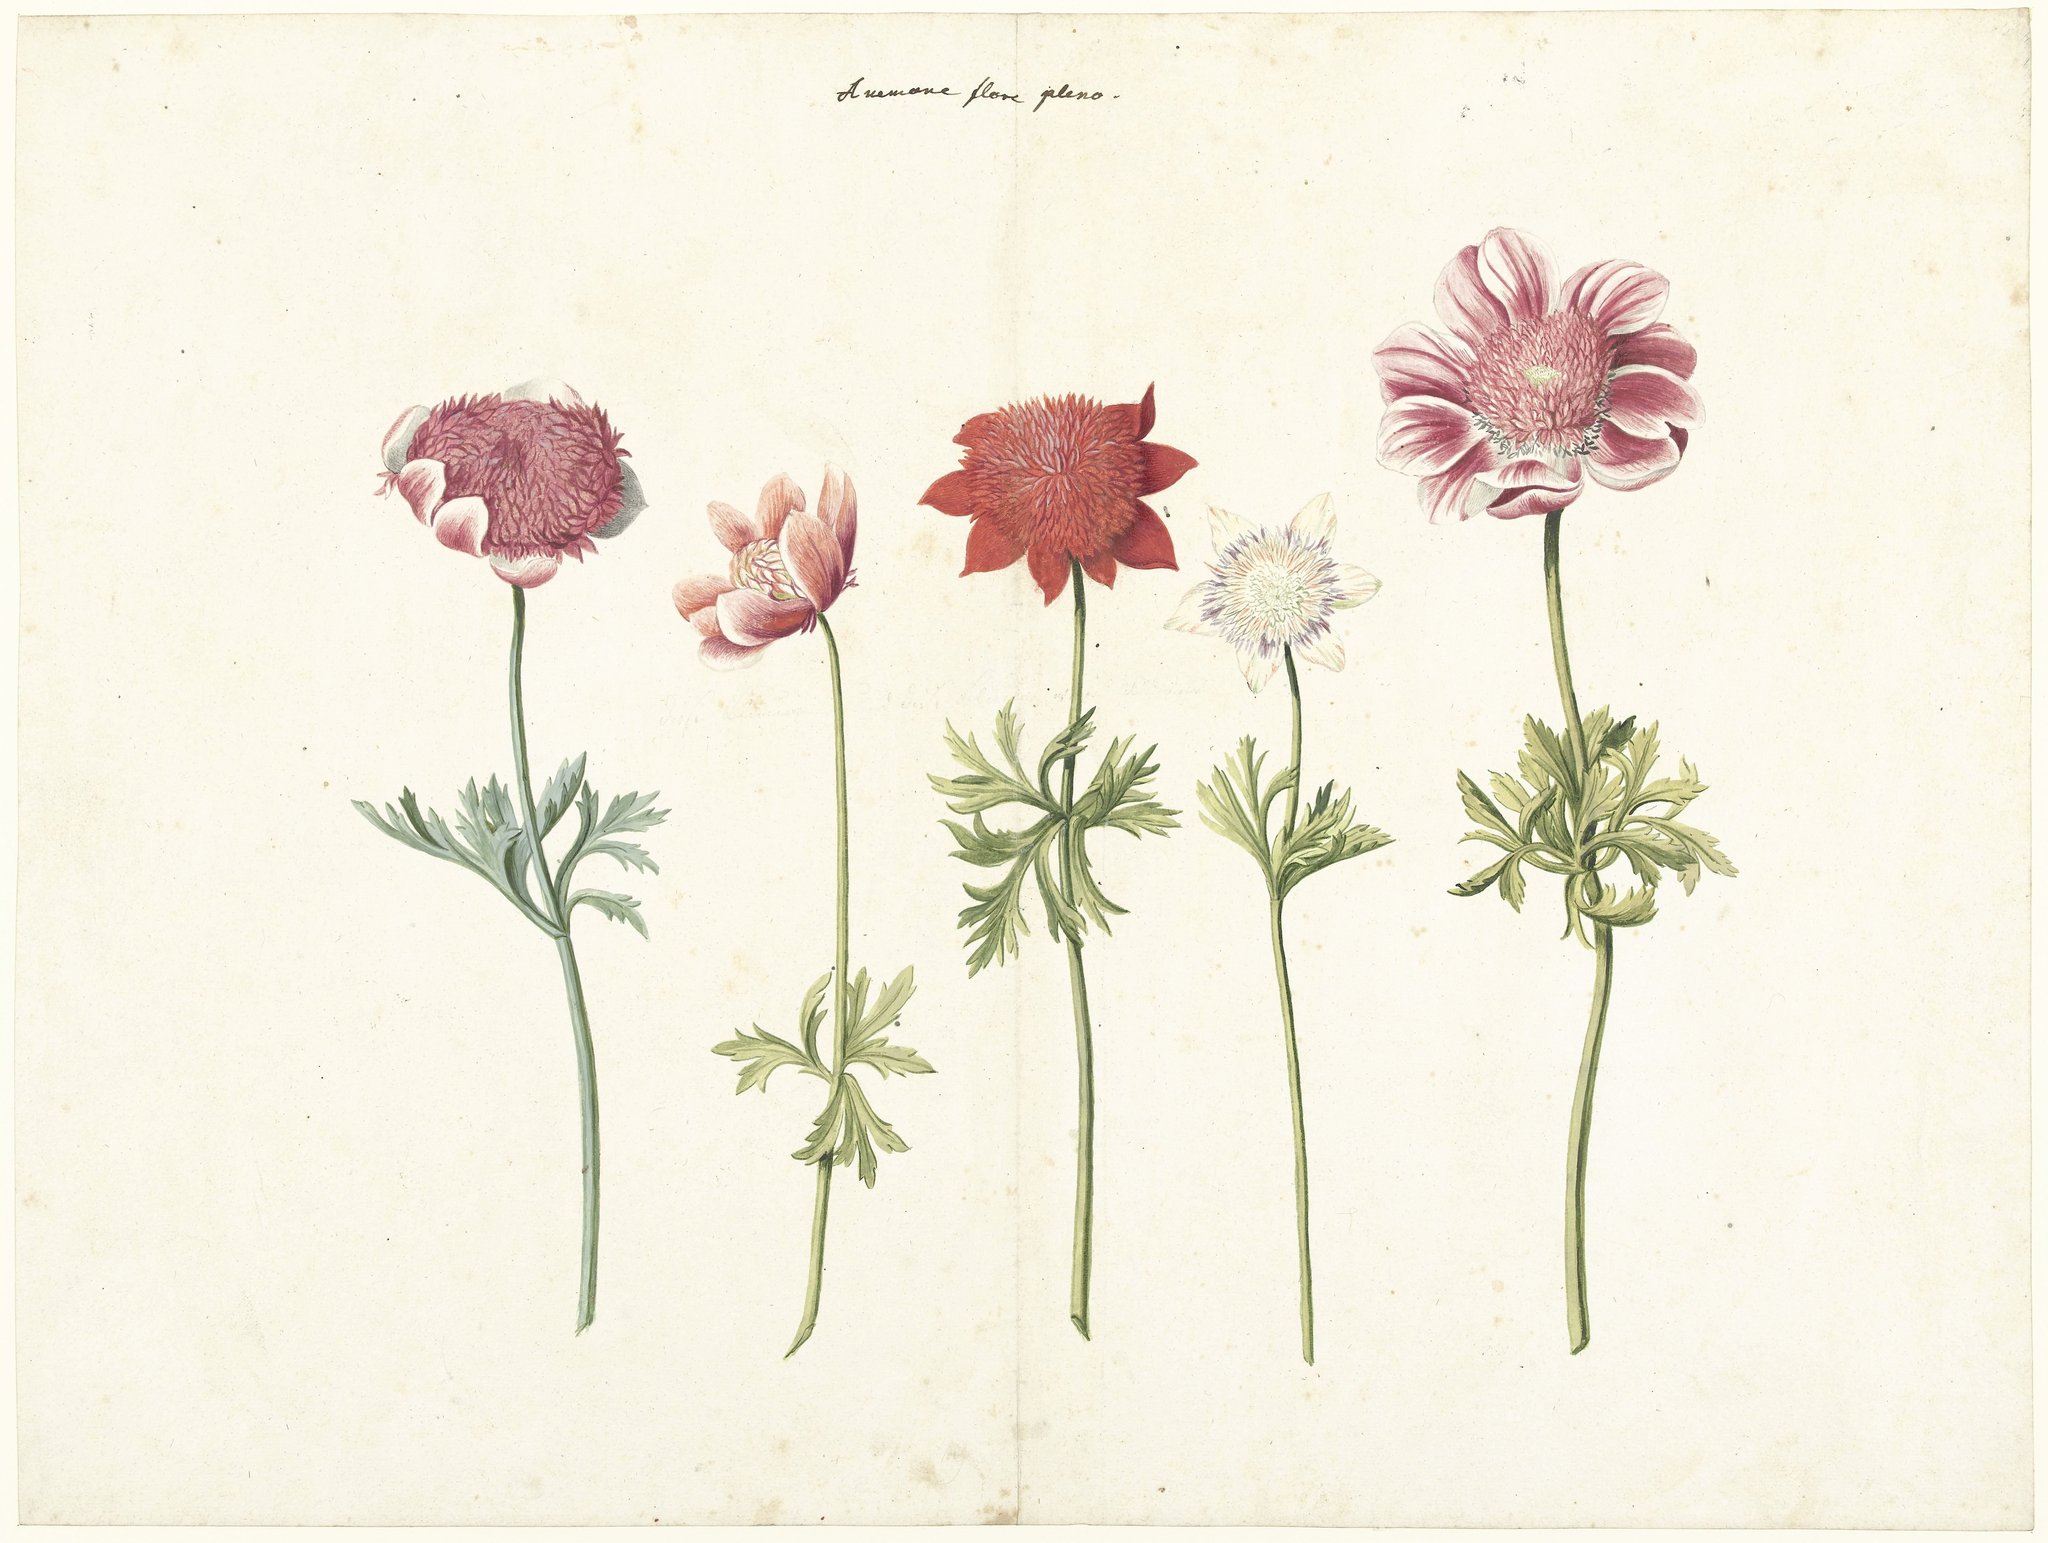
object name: watercolor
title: Five Studies of Anemones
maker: Anonymous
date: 1760-1770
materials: paper, watercolor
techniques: brush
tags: flowers: anemone